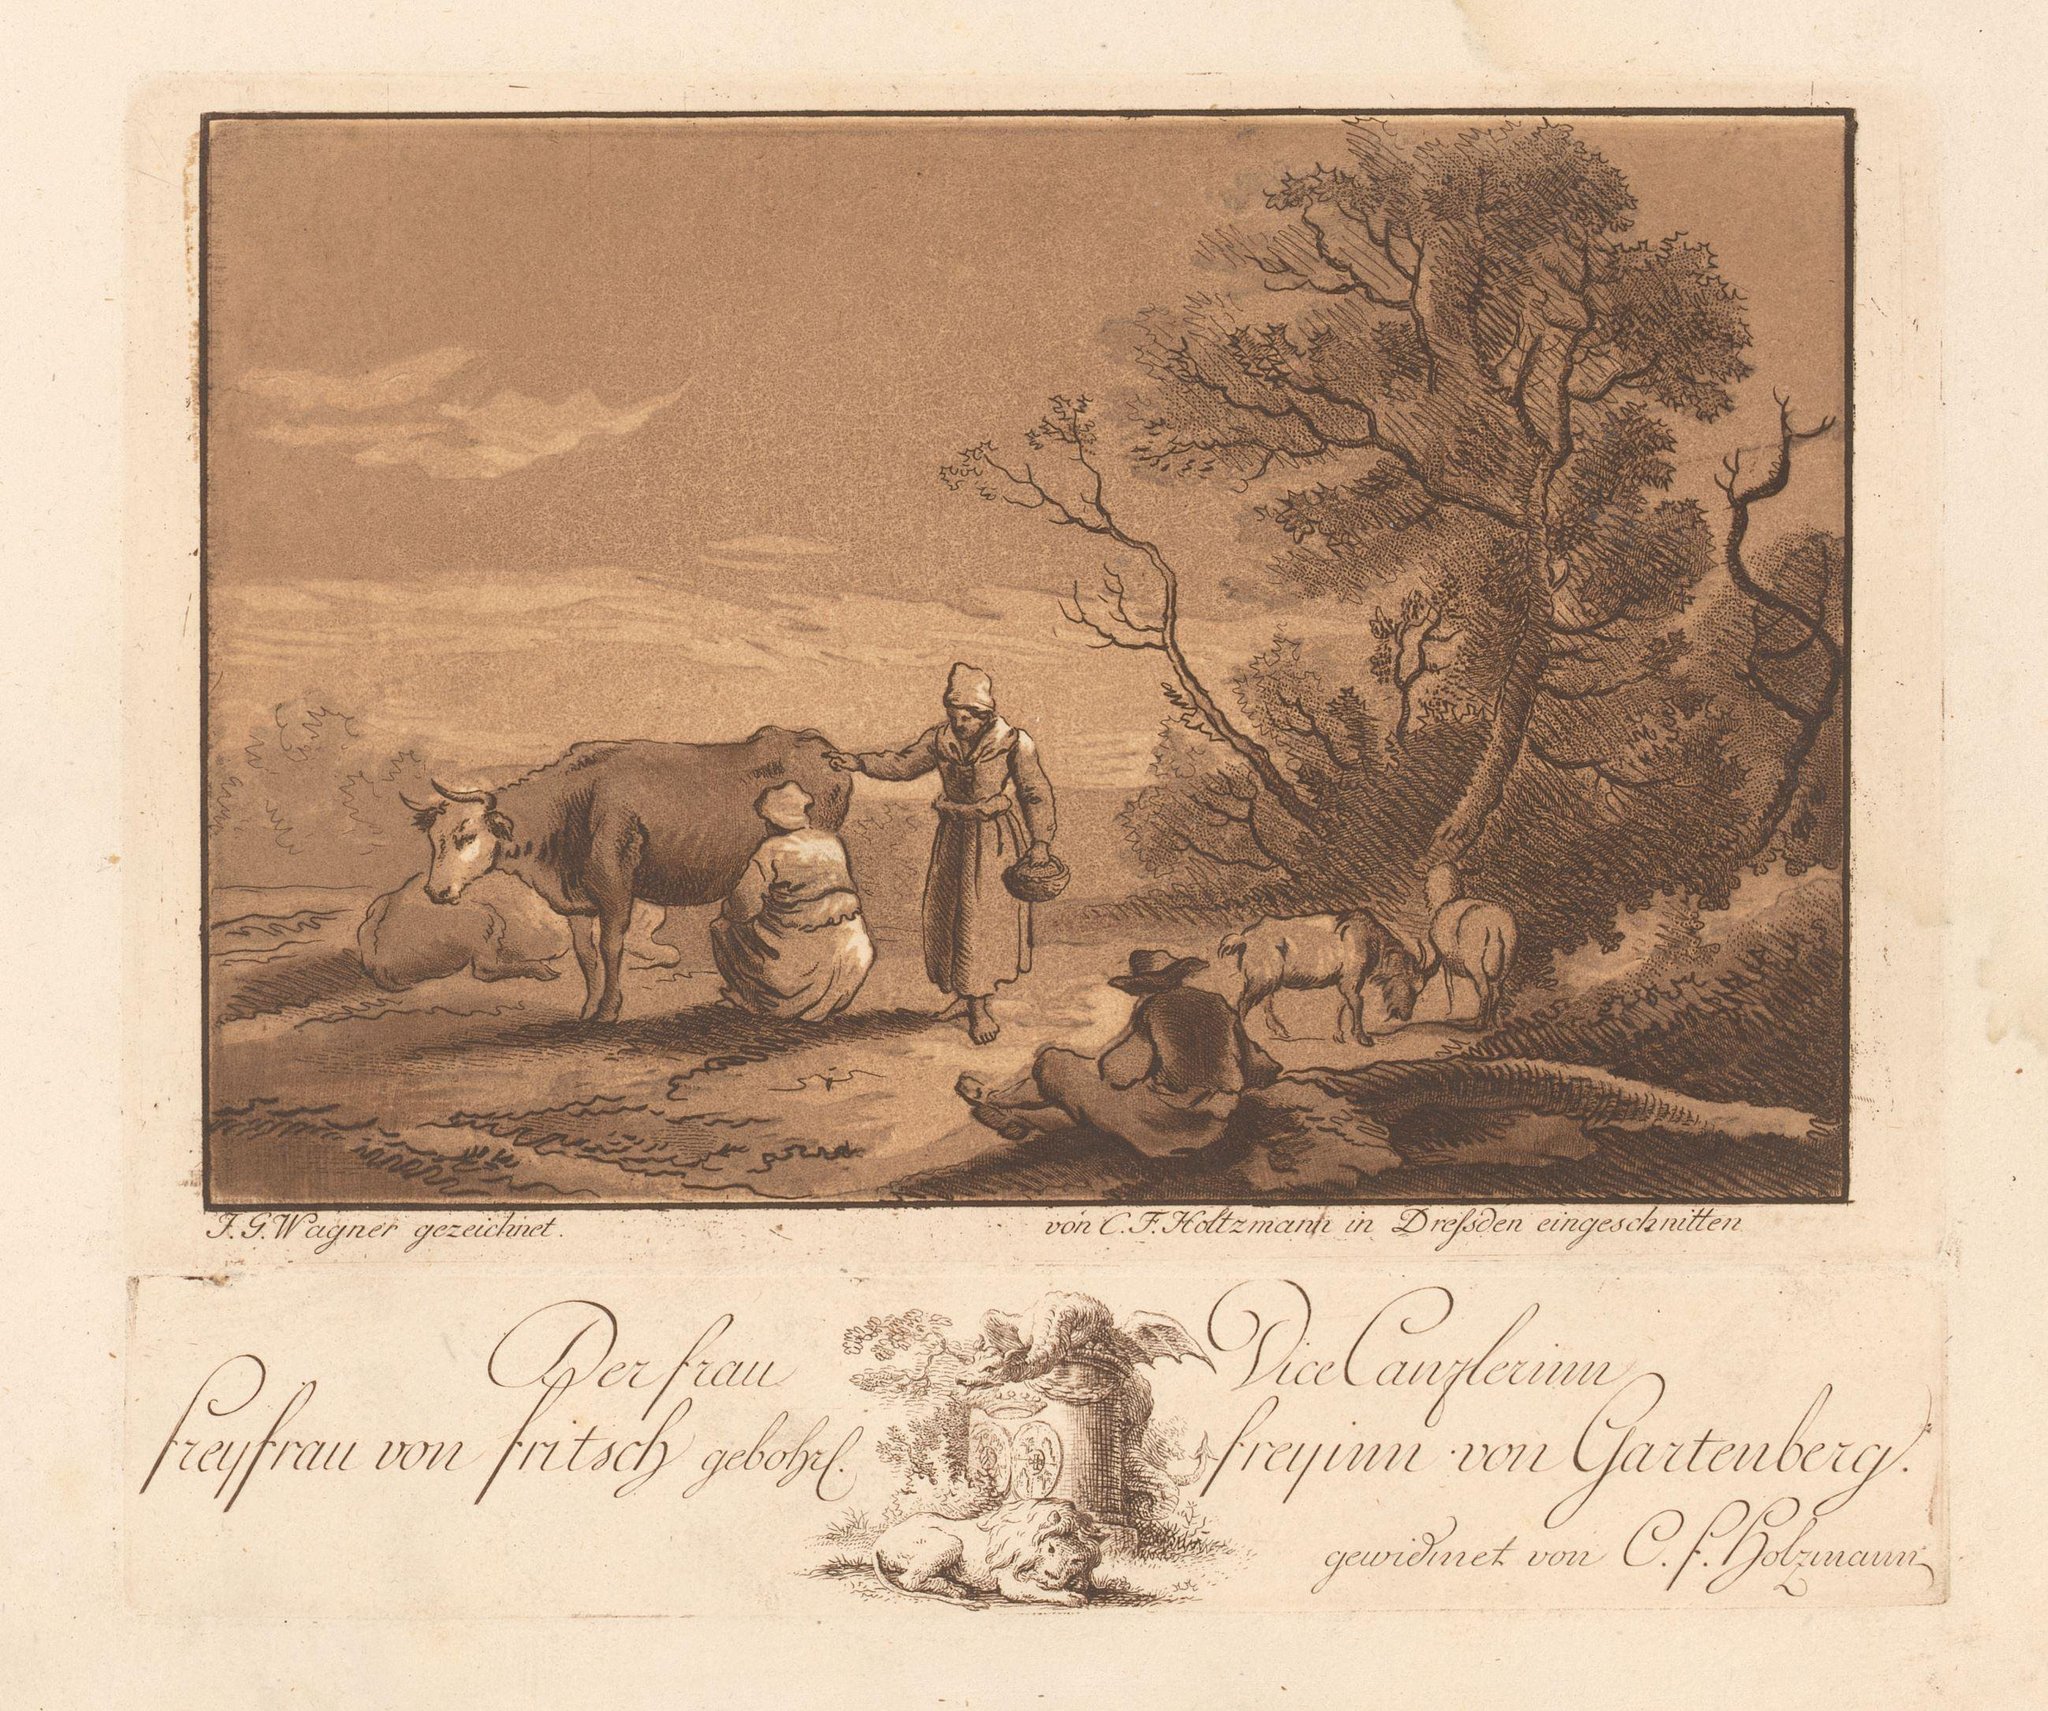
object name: print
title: Landschap met herders en runderen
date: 1750-1811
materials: paper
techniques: etching, intaglio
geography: dresden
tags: cattle, dragon, landscapes (+ landscape with figures, staffage), milking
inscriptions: collector's mark: Lugt 2760, collector's mark: Lugt 2228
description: Tekst in het Duits in de ondermarge. Prent maakt deel uit van een album.